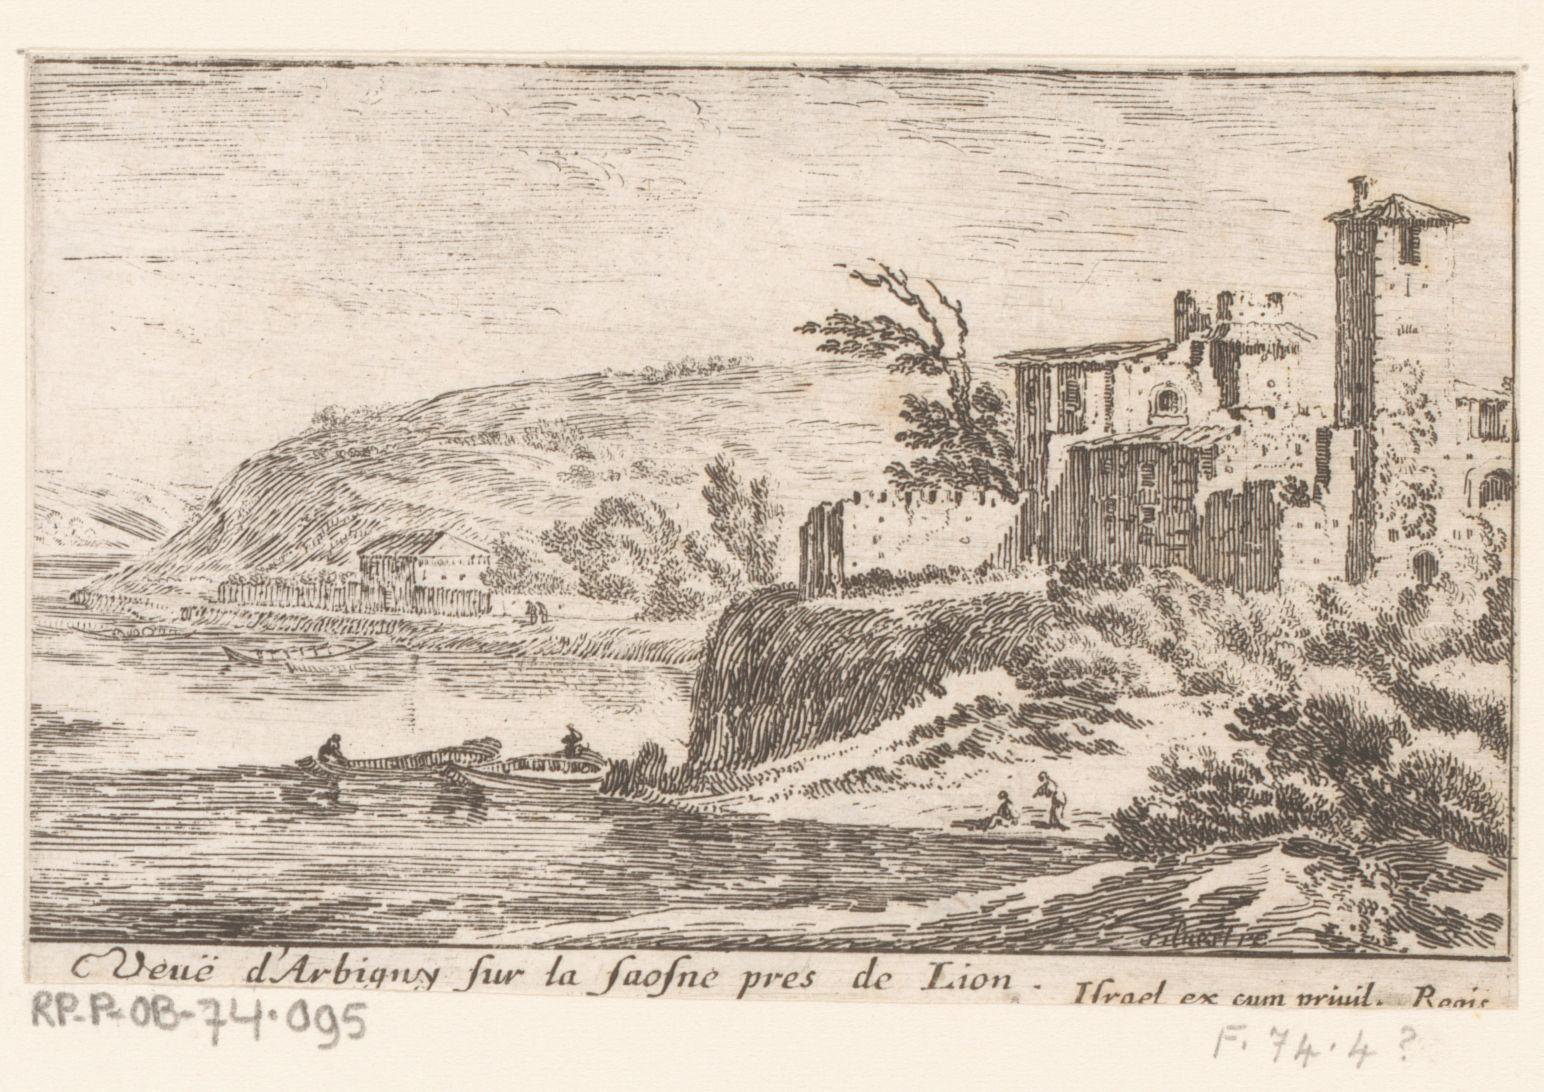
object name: print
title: Veue d'Arbigny sur la saosne pres de Lion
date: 1631-1661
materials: paper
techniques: etching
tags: city-view, and landscape with man-made constructions (+ city(-scape) with figures, staffage)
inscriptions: collector's mark: Lugt 240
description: Prent maakt deel uit van een ongenummerde serie van zeven prenten.